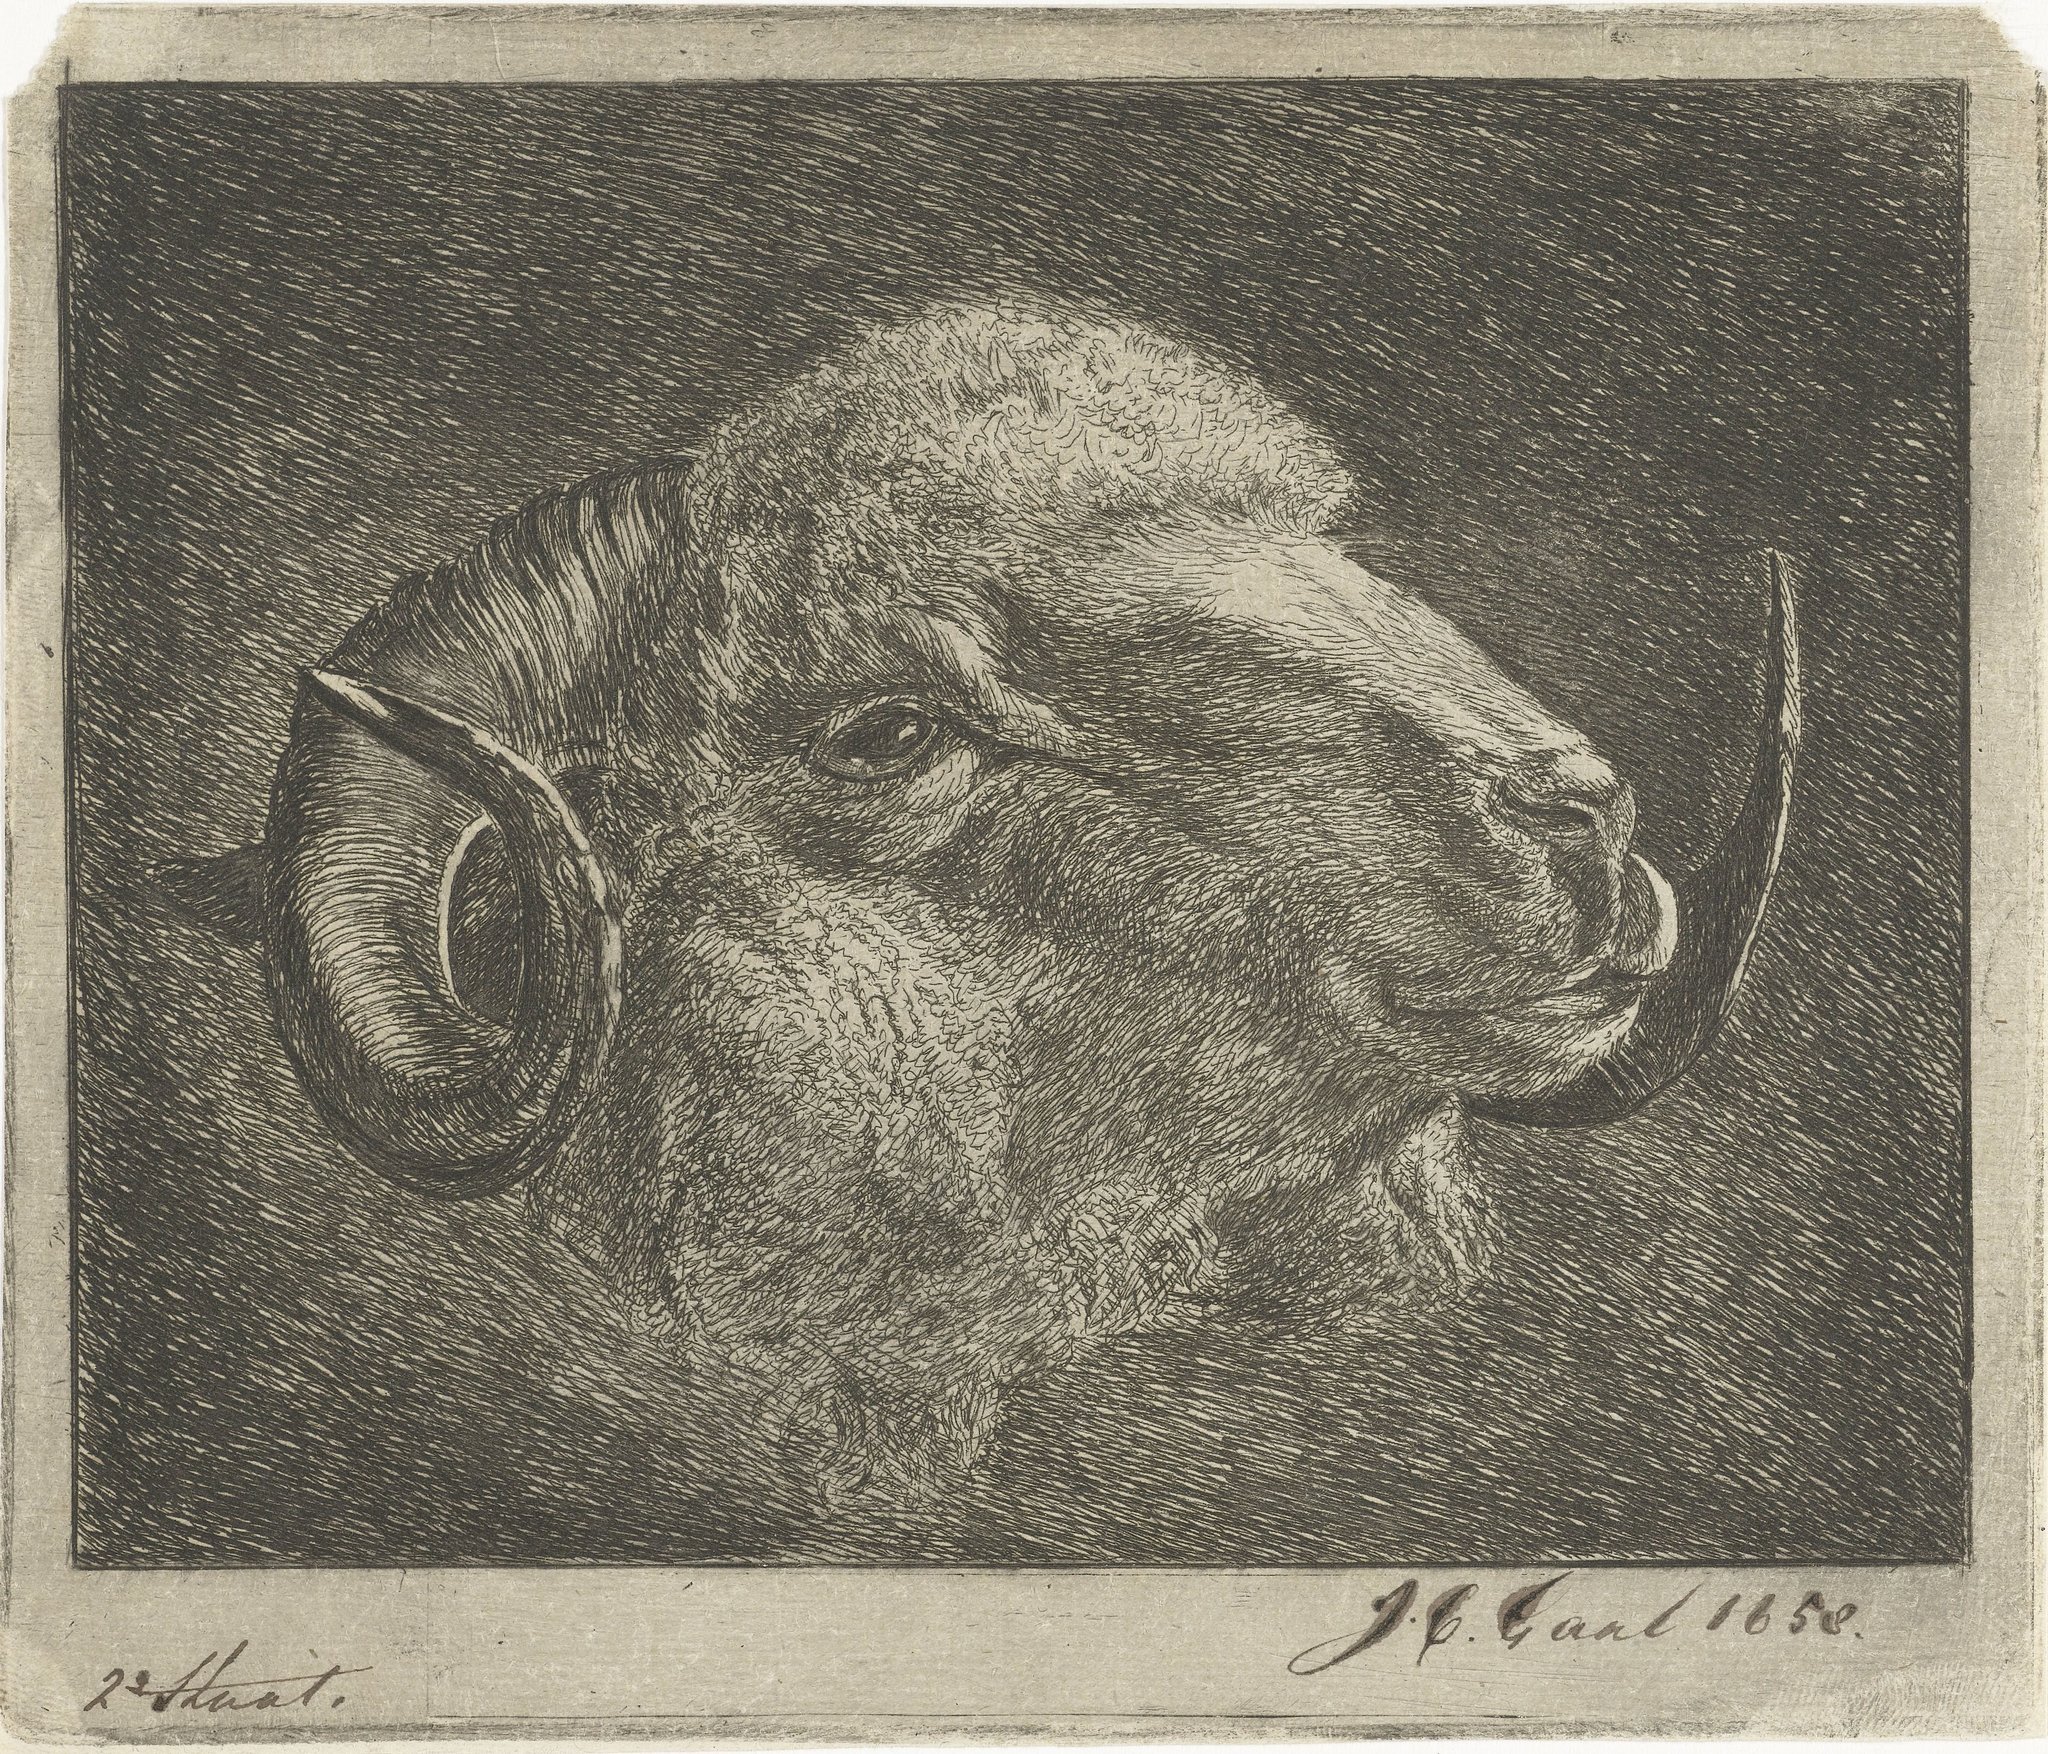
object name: print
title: Kop van een ram met naar achteren gedraaide hoorns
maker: jacobus cornelis gaal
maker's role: print maker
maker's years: 1796-1866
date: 1858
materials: paper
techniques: etching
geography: netherlands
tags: ram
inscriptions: collector's mark: Lugt 2228